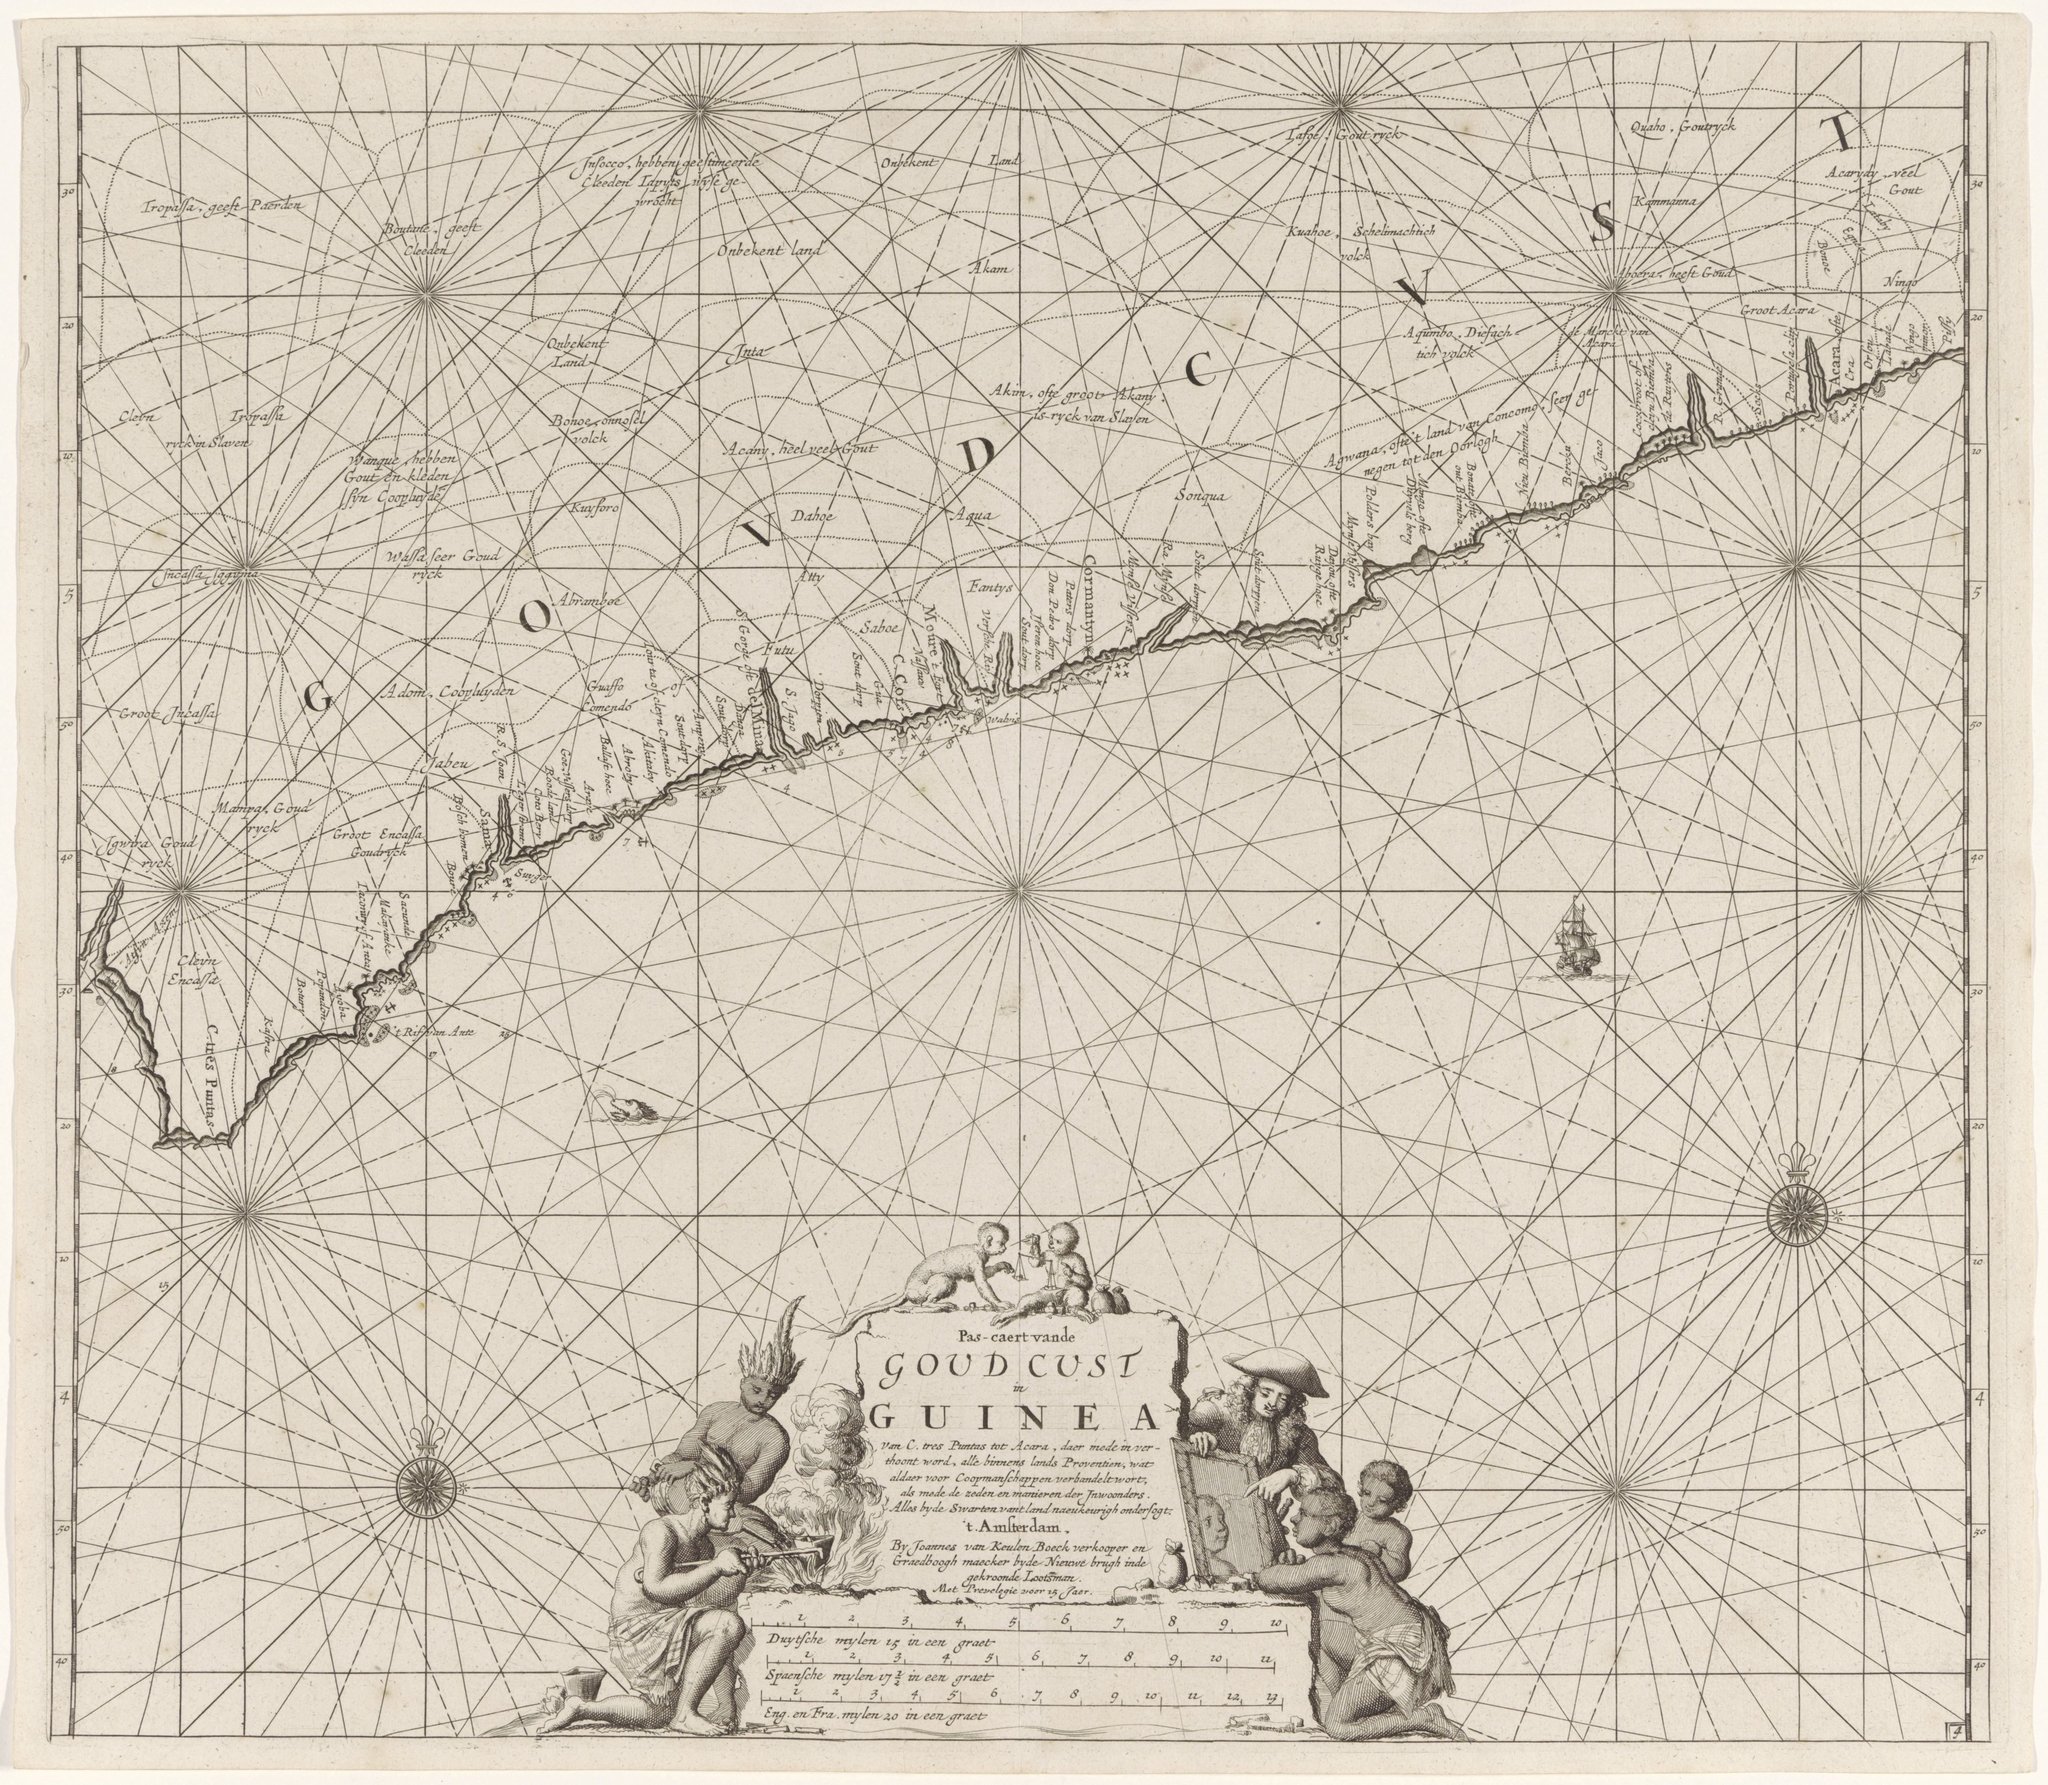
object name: print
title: Kaart van een gedeelte van de Goudkust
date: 1683-1799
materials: paper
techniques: engraving, etching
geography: amsterdam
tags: stirring up a fire, monkeys, apes, africans, mirror, reflection (in a mirror)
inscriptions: collector's mark: Lugt 2228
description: Kaart van een gedeelte van de Goudkust, met twee kompasrozen, het Noorden ligt boven. Middenonder de titel, het uitgeversadres en de schaalverdeling, weergegeven in Duitse, Spaanse en Engelse of Franse mijlen. Links van de titel maken twee donkere mannen met verentooien een vuur. Rechts wijst een blanke man twee donkere mensen op hun spiegelbeeld in een spiegel. In het midden wegen twee aapjes geld.